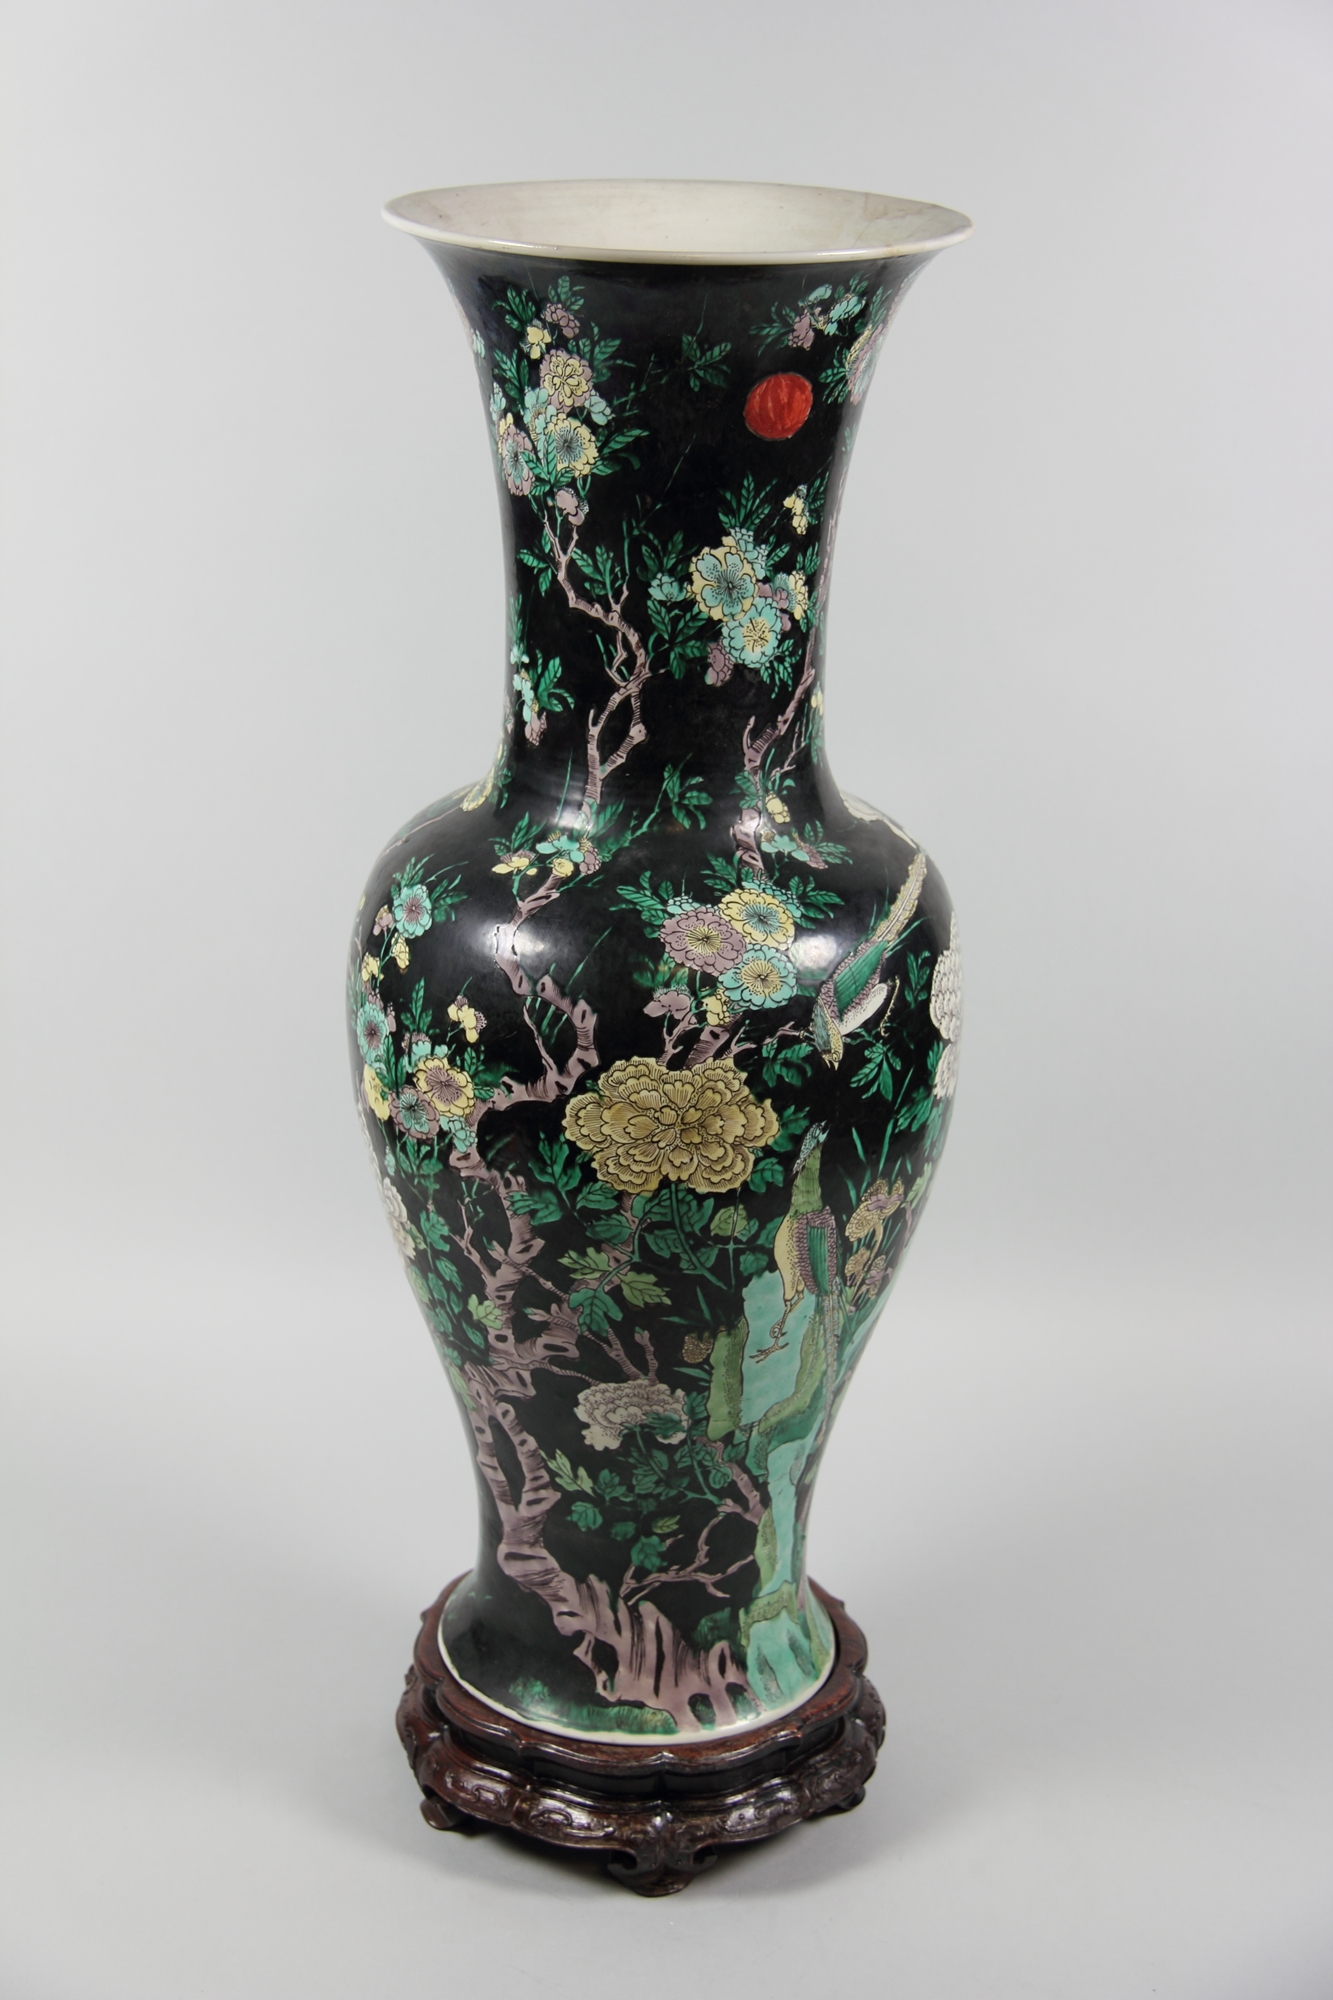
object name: vase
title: Vase with birds and flowers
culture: chinese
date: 1801-1900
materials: enamel, porcelain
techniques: painting, polychrome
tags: birds,flowers,leaves